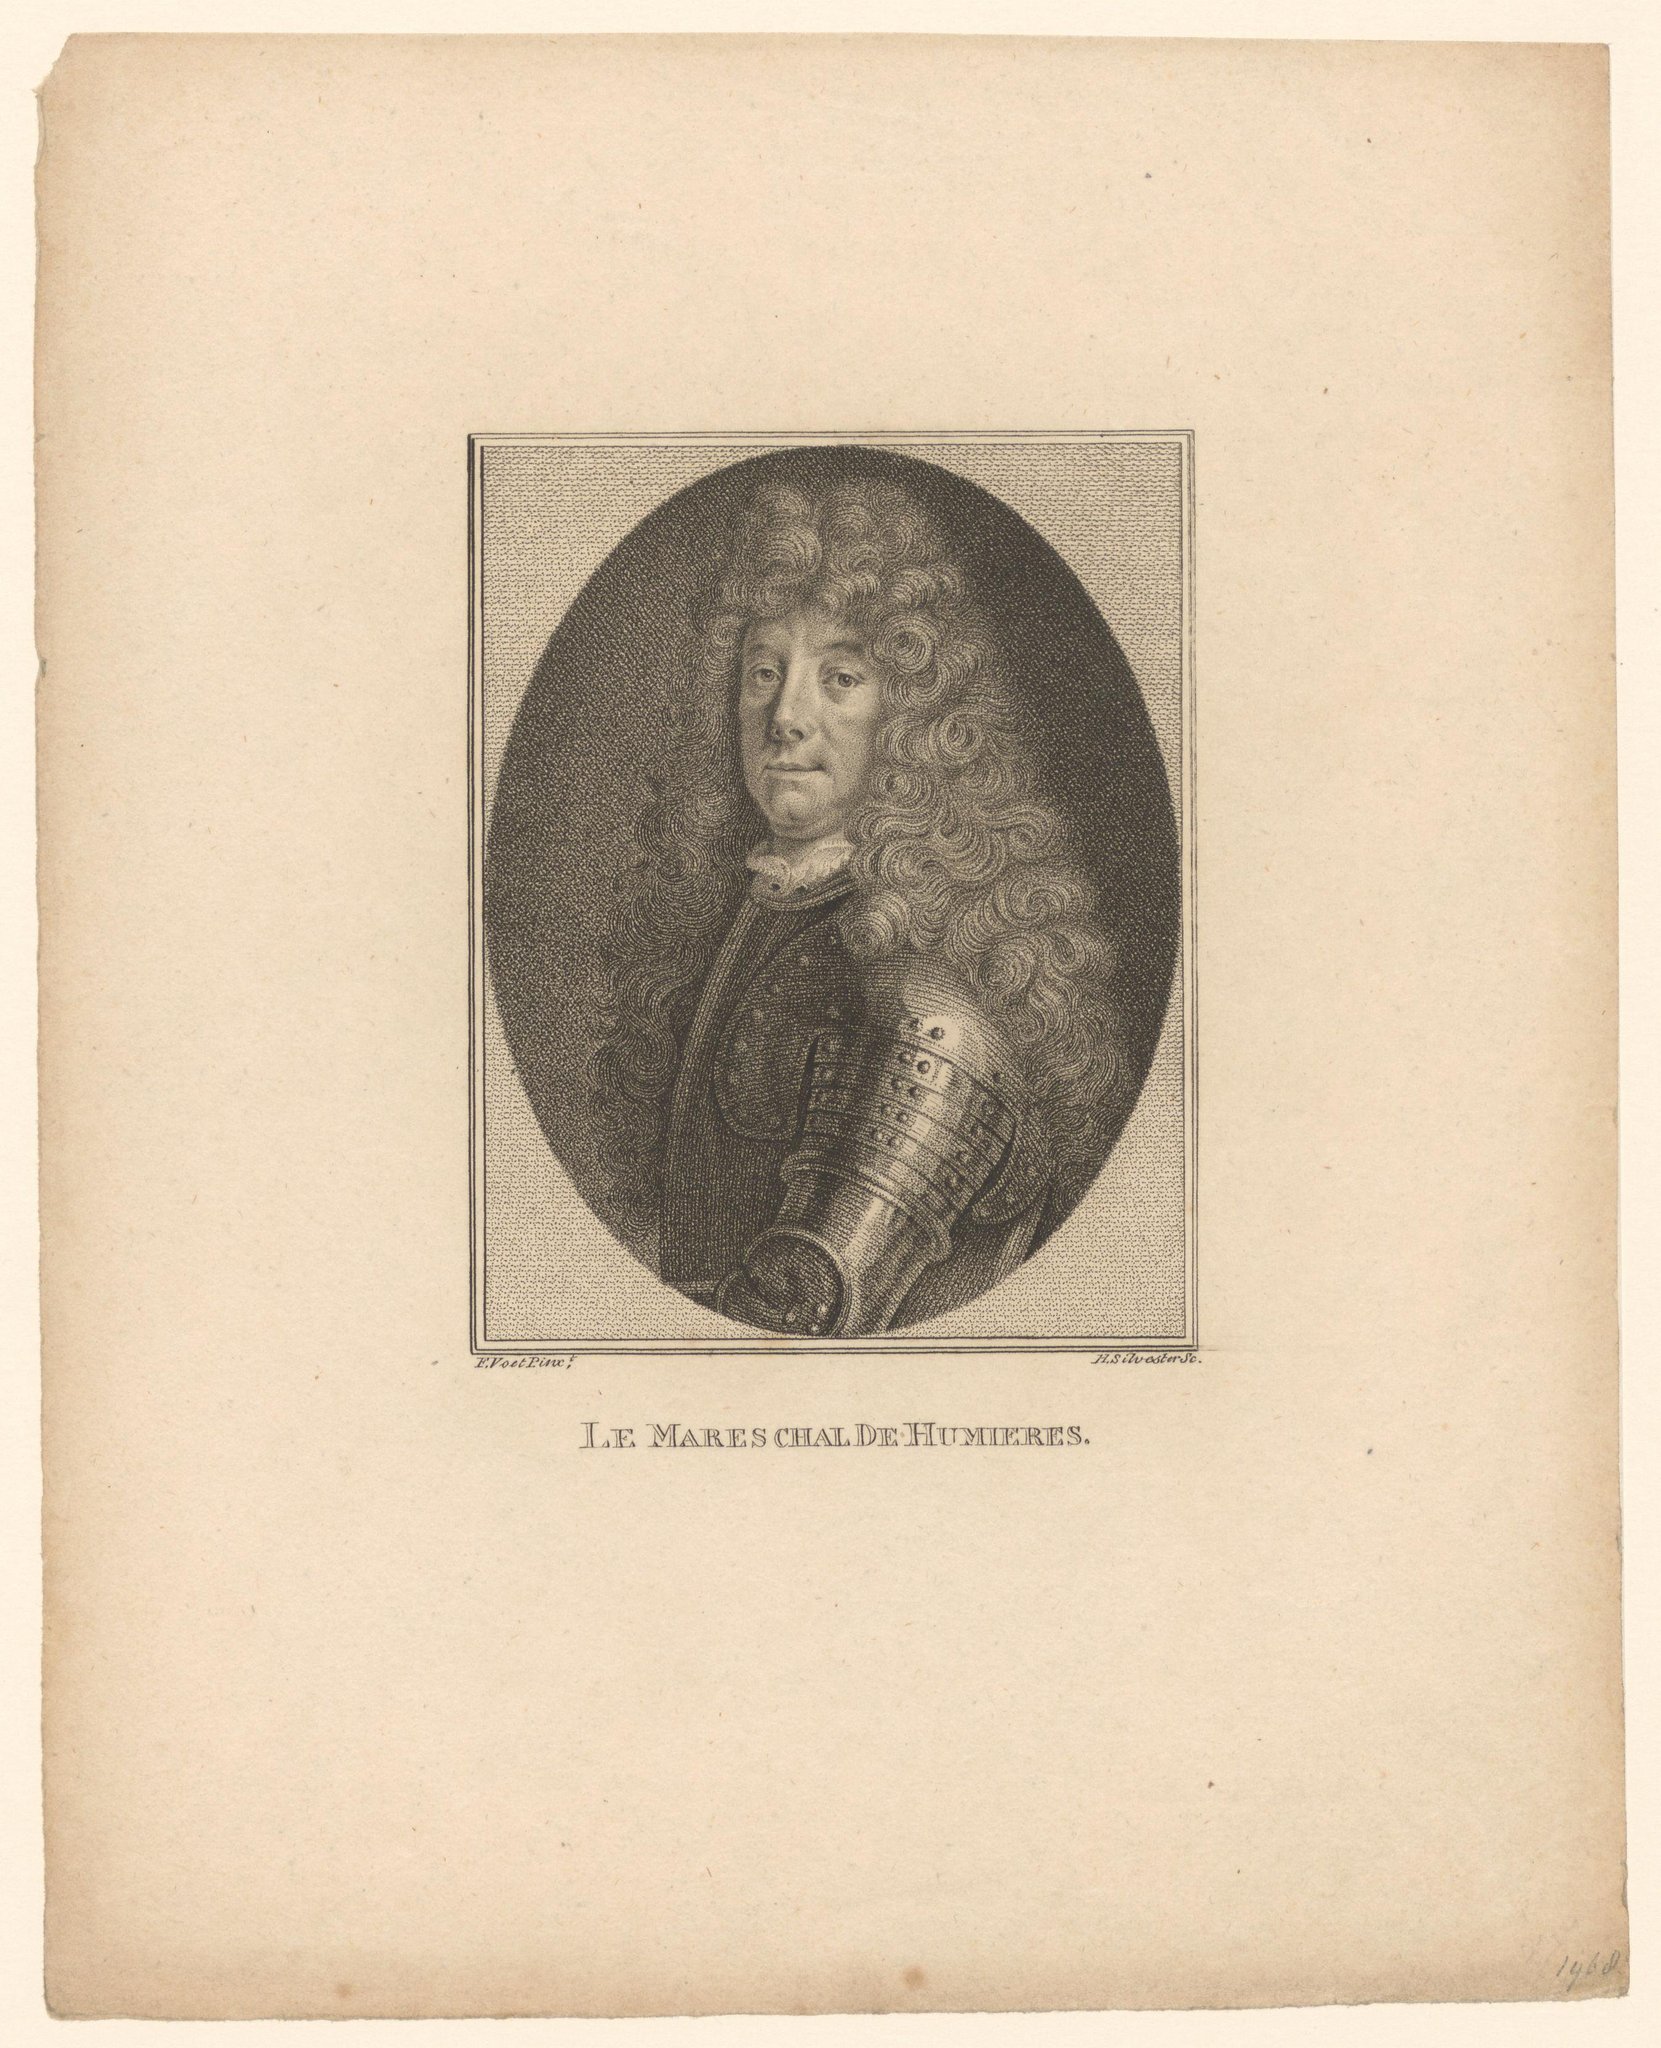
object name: print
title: Le Mareschal de Humieres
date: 1808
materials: paper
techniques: engraving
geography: great britain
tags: louis de crévant (hertog van humières), commander-in-chief, general, marshal, historical persons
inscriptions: collector's mark: Lugt 2228